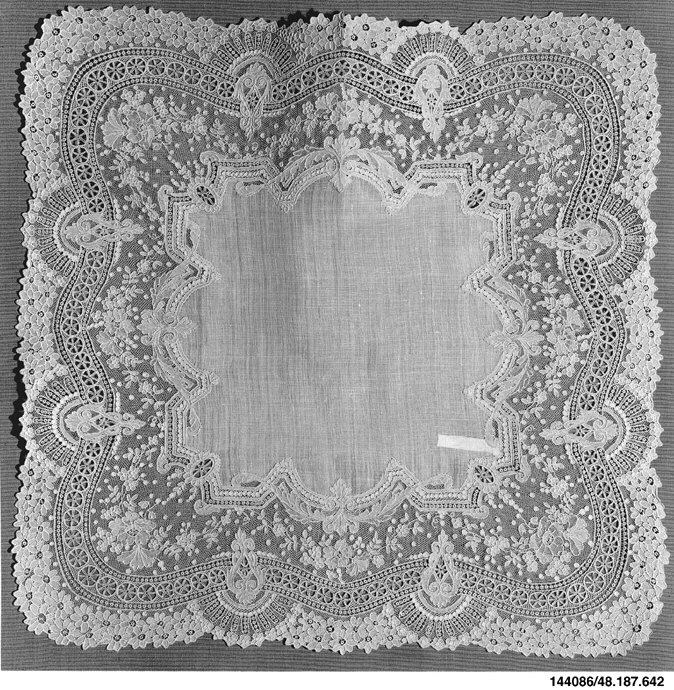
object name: handkerchief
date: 1867-1900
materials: linen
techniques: lace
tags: flowers